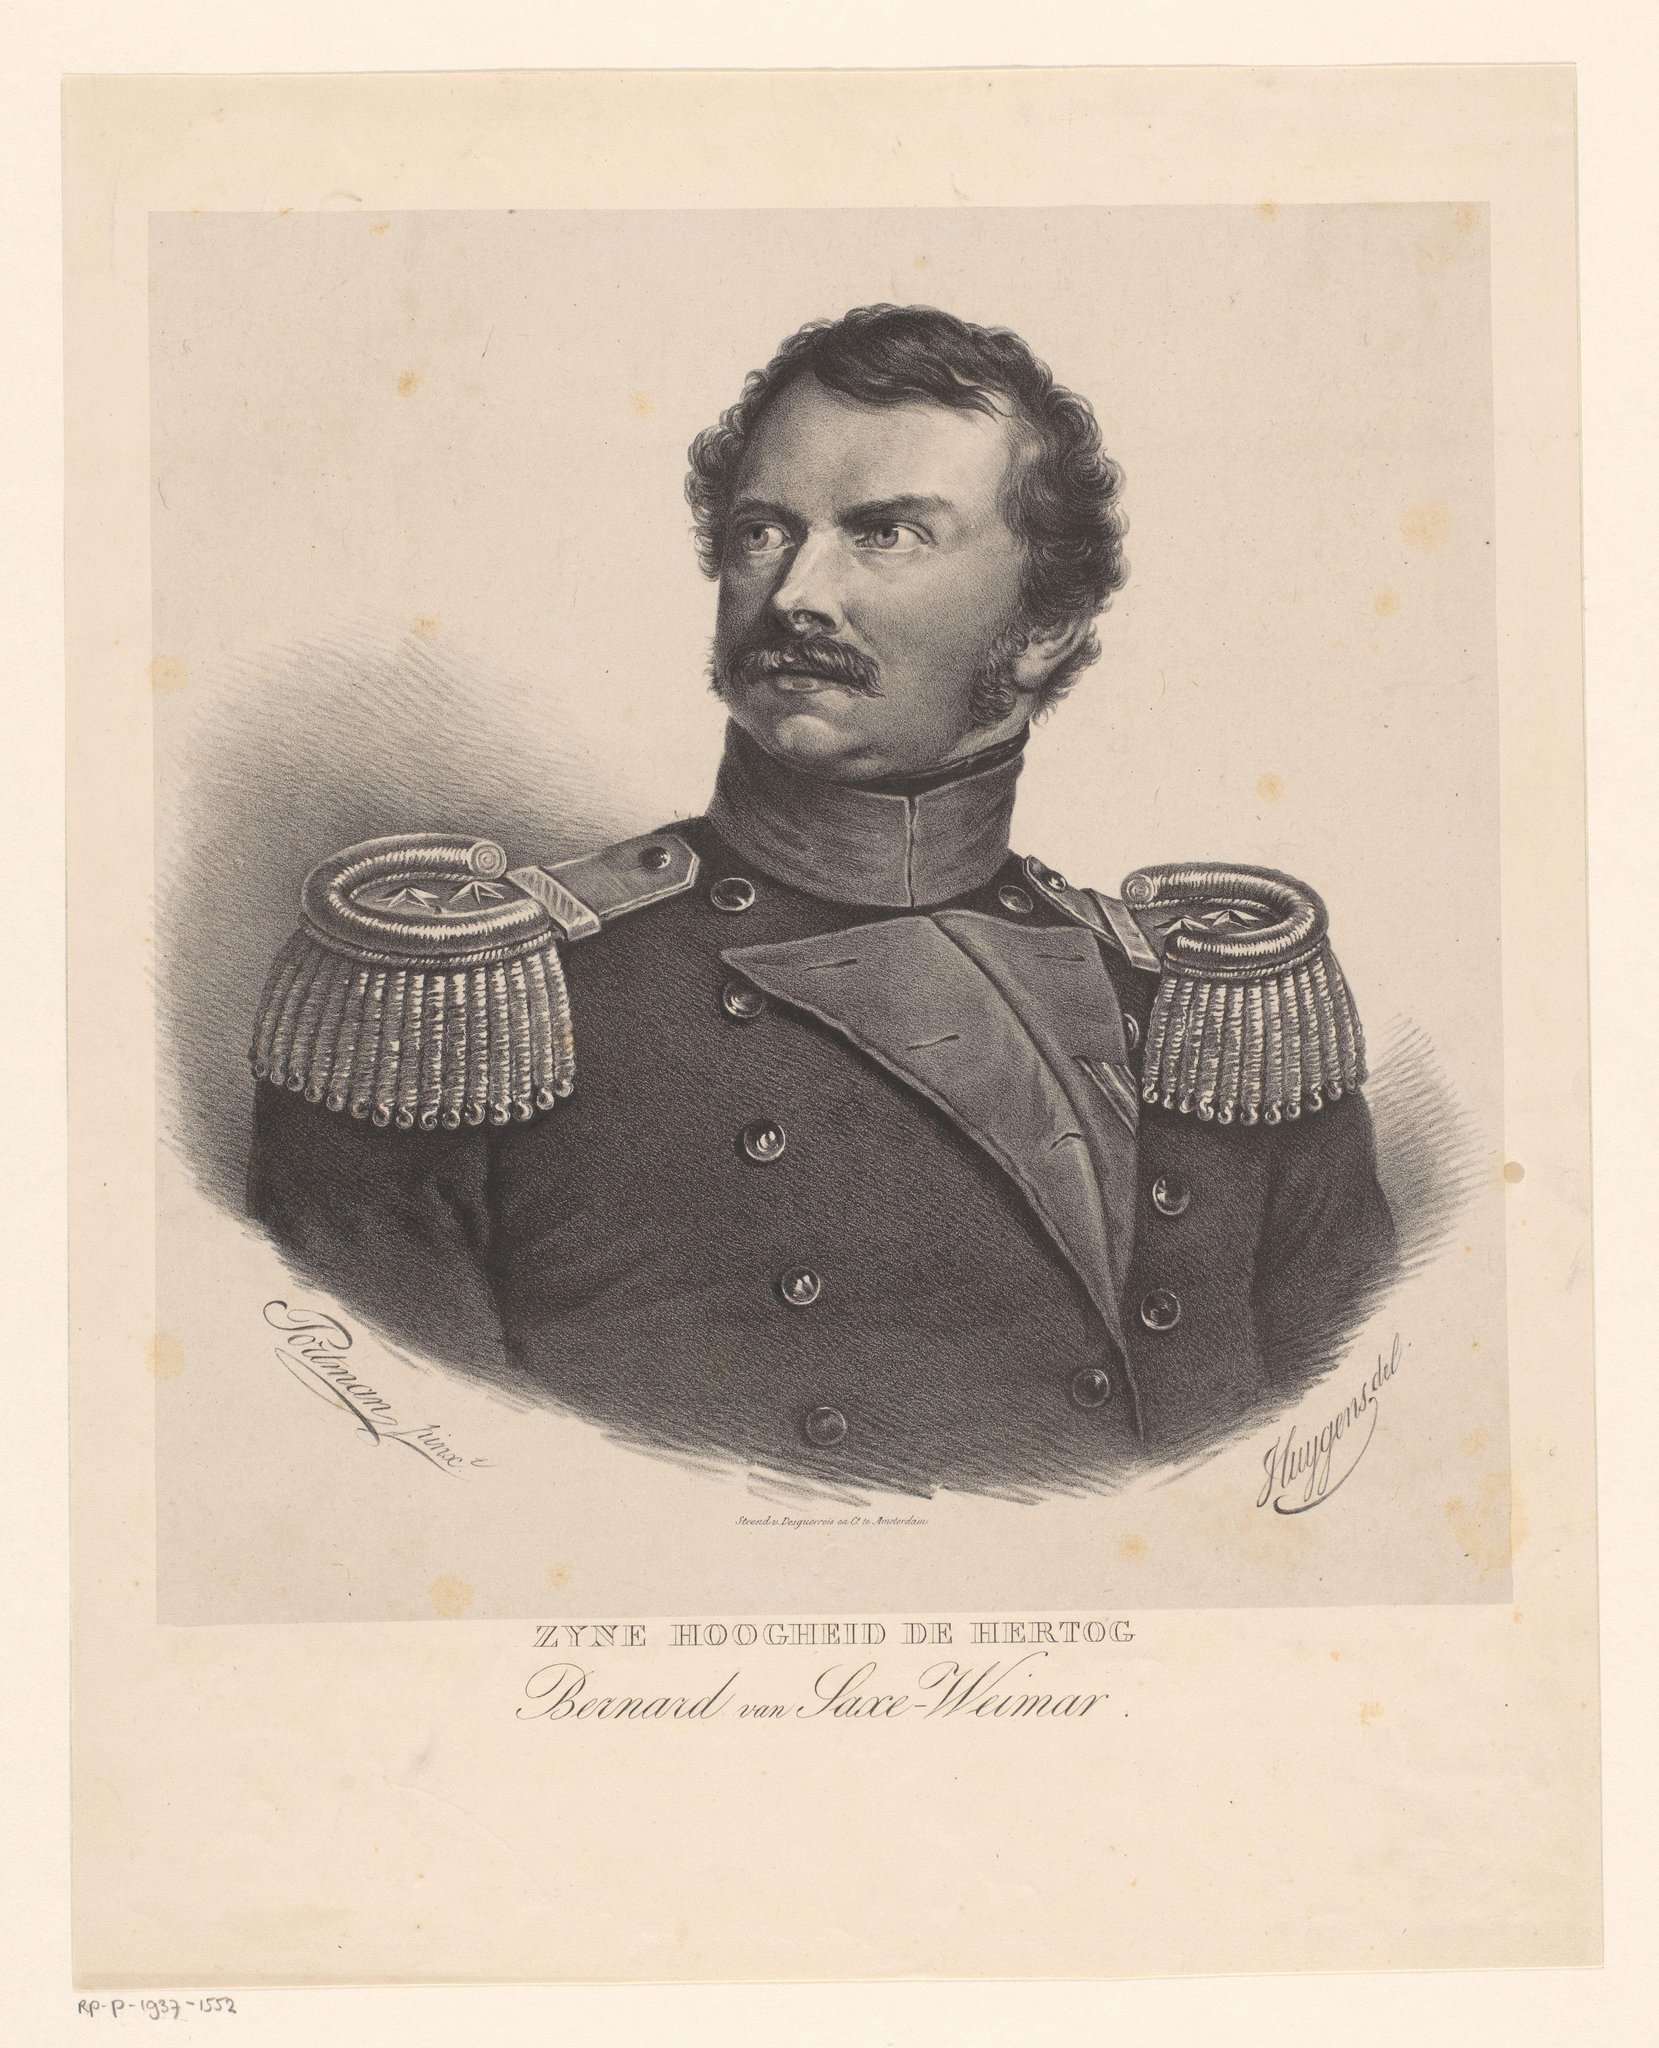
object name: print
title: Portret van Karel Bernard hertog van Saxen-Weimar-Eisenach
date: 1831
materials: paper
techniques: lithograph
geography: netherlands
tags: karel bernhard (hertog van saksen-weimar-eisenach), head turned to the left, historical persons (+ (full) bust portrait)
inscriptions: collector's mark: Lugt 2228, collector's mark: Lugt 2760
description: De geportretteerde draagt een militair uniform. Onder het portret zijn naam.